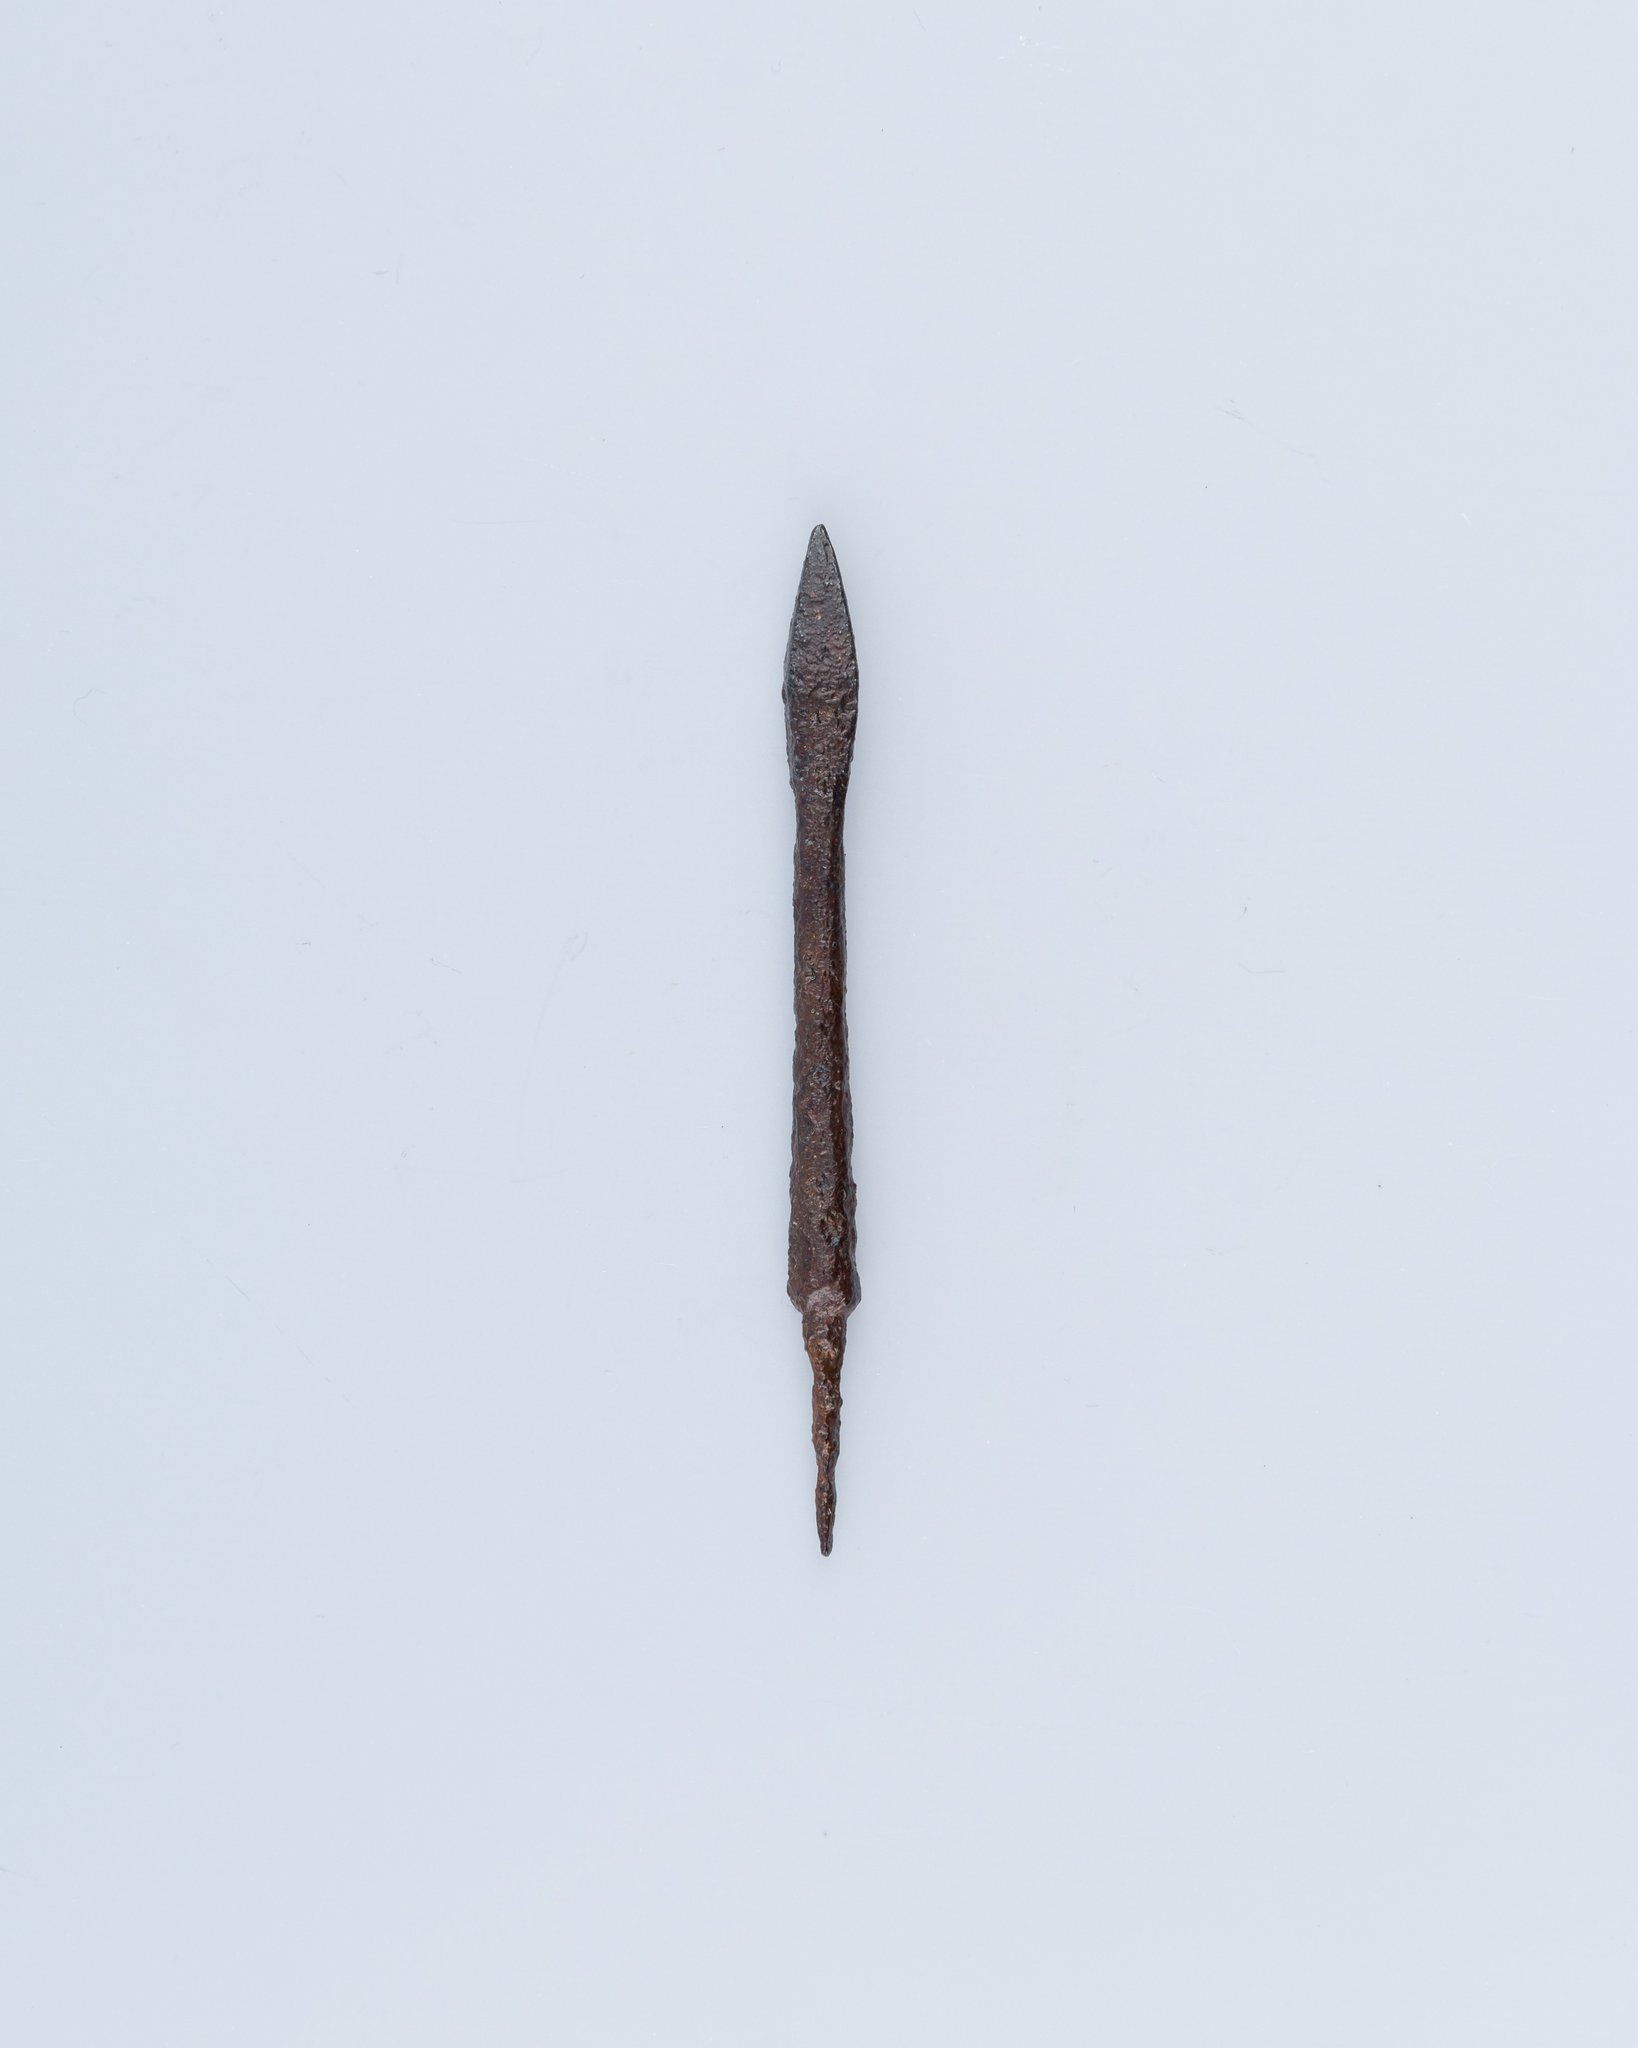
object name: arrowhead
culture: tibetan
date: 1401-1700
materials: iron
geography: tibet